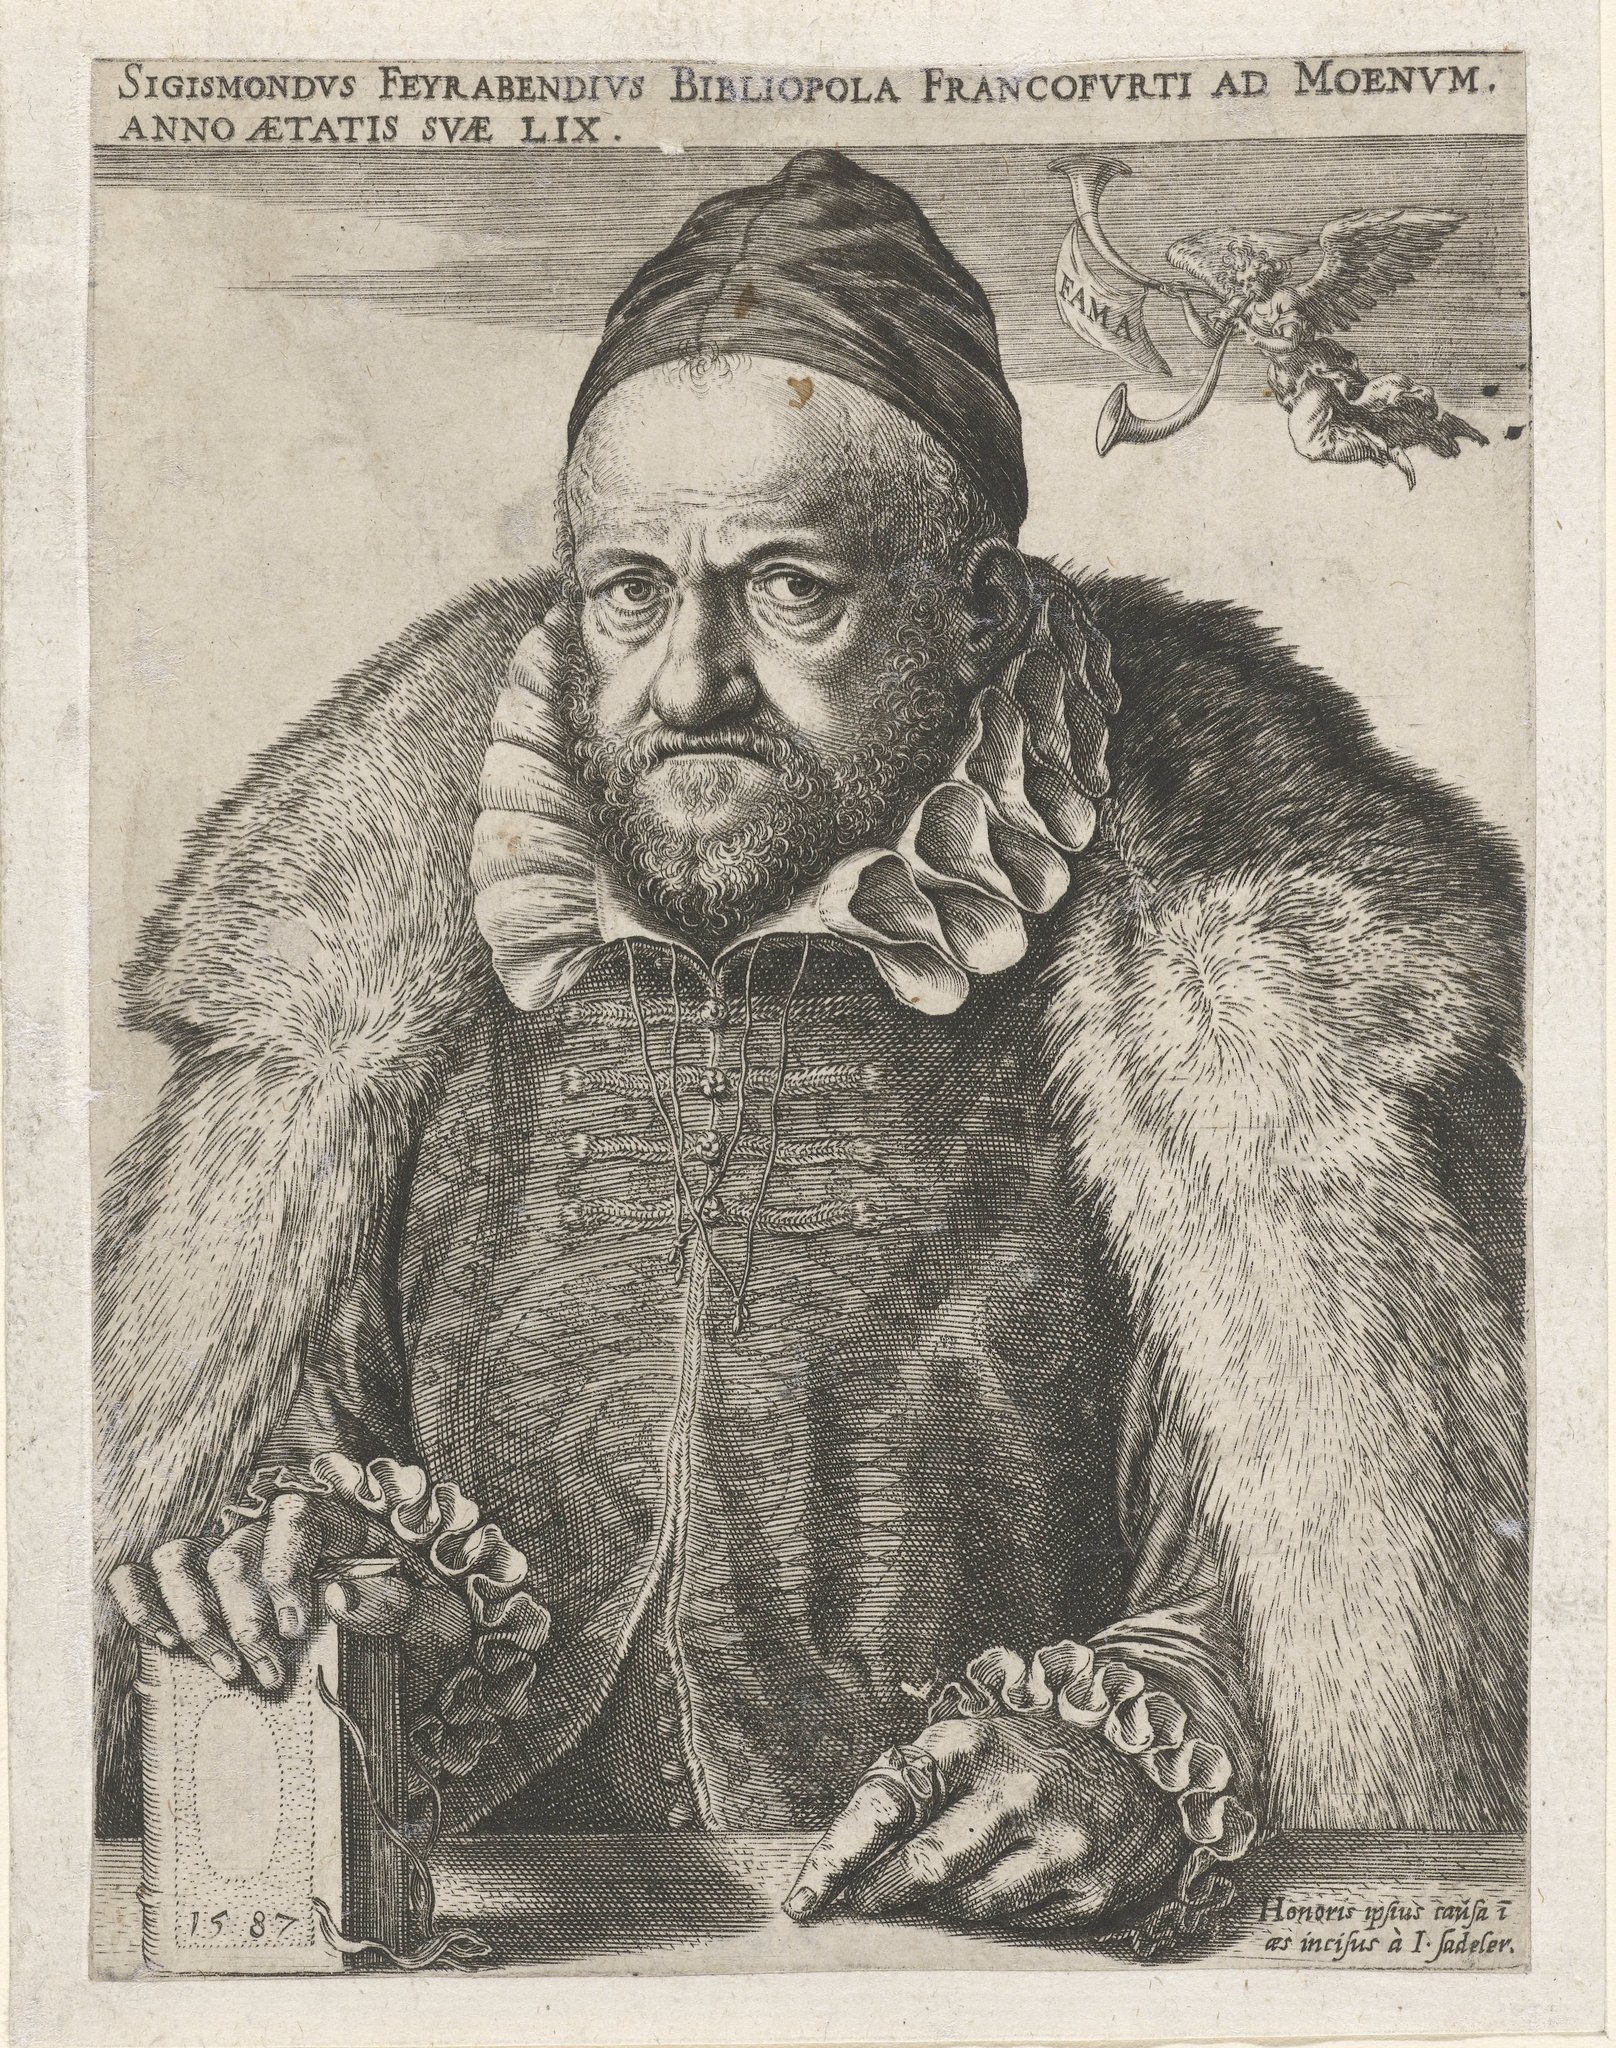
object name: print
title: Portret van Sigismund Feyerabend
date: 1587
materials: paper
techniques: engraving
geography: frankfurt am main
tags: publisher, bookseller, sigmund feyerabend, production of printed matter, book-production (+ portrait of scholar, scientist), publishing, publisher, fame; 'fama', 'fama buona', 'fama chiara' (ripa)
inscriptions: collector's mark: Lugt 240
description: Portret van de drukker en uitgever Sigismund Feyerabend, op 59-jarige leeftijd. Zijn rechterhand rust op een boek. In de rechterbovenhoek de personificatie van Roem (Fama).